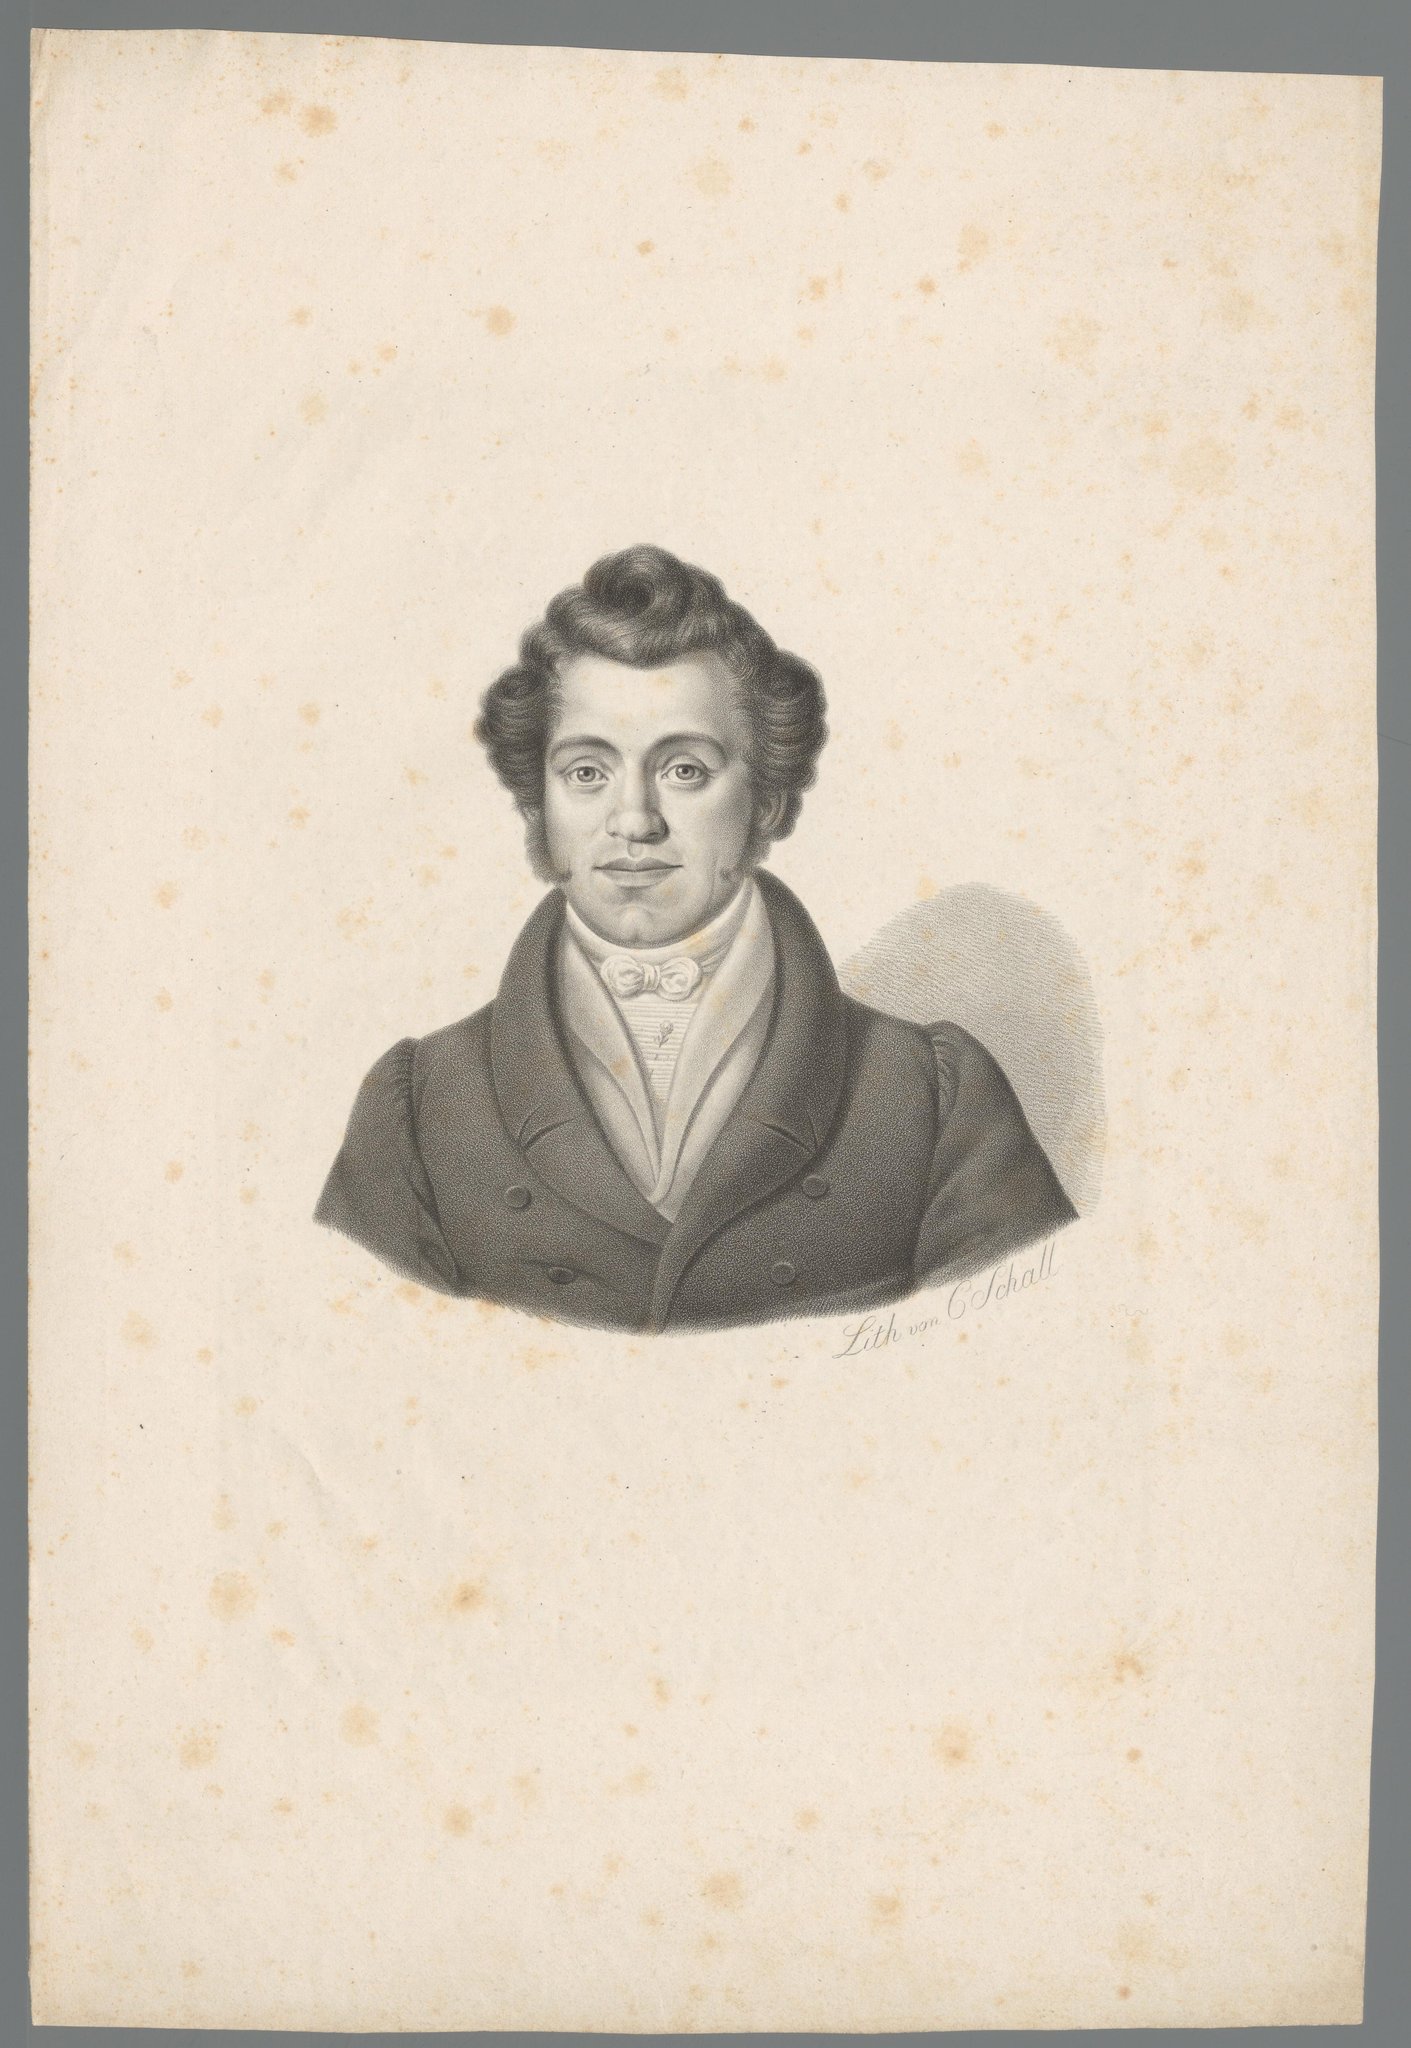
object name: print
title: Portret van een onbekende man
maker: j.c. schall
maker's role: print maker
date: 1820-1875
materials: paper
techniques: lithograph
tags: adult man, historical persons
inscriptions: collector's mark: Lugt 2228